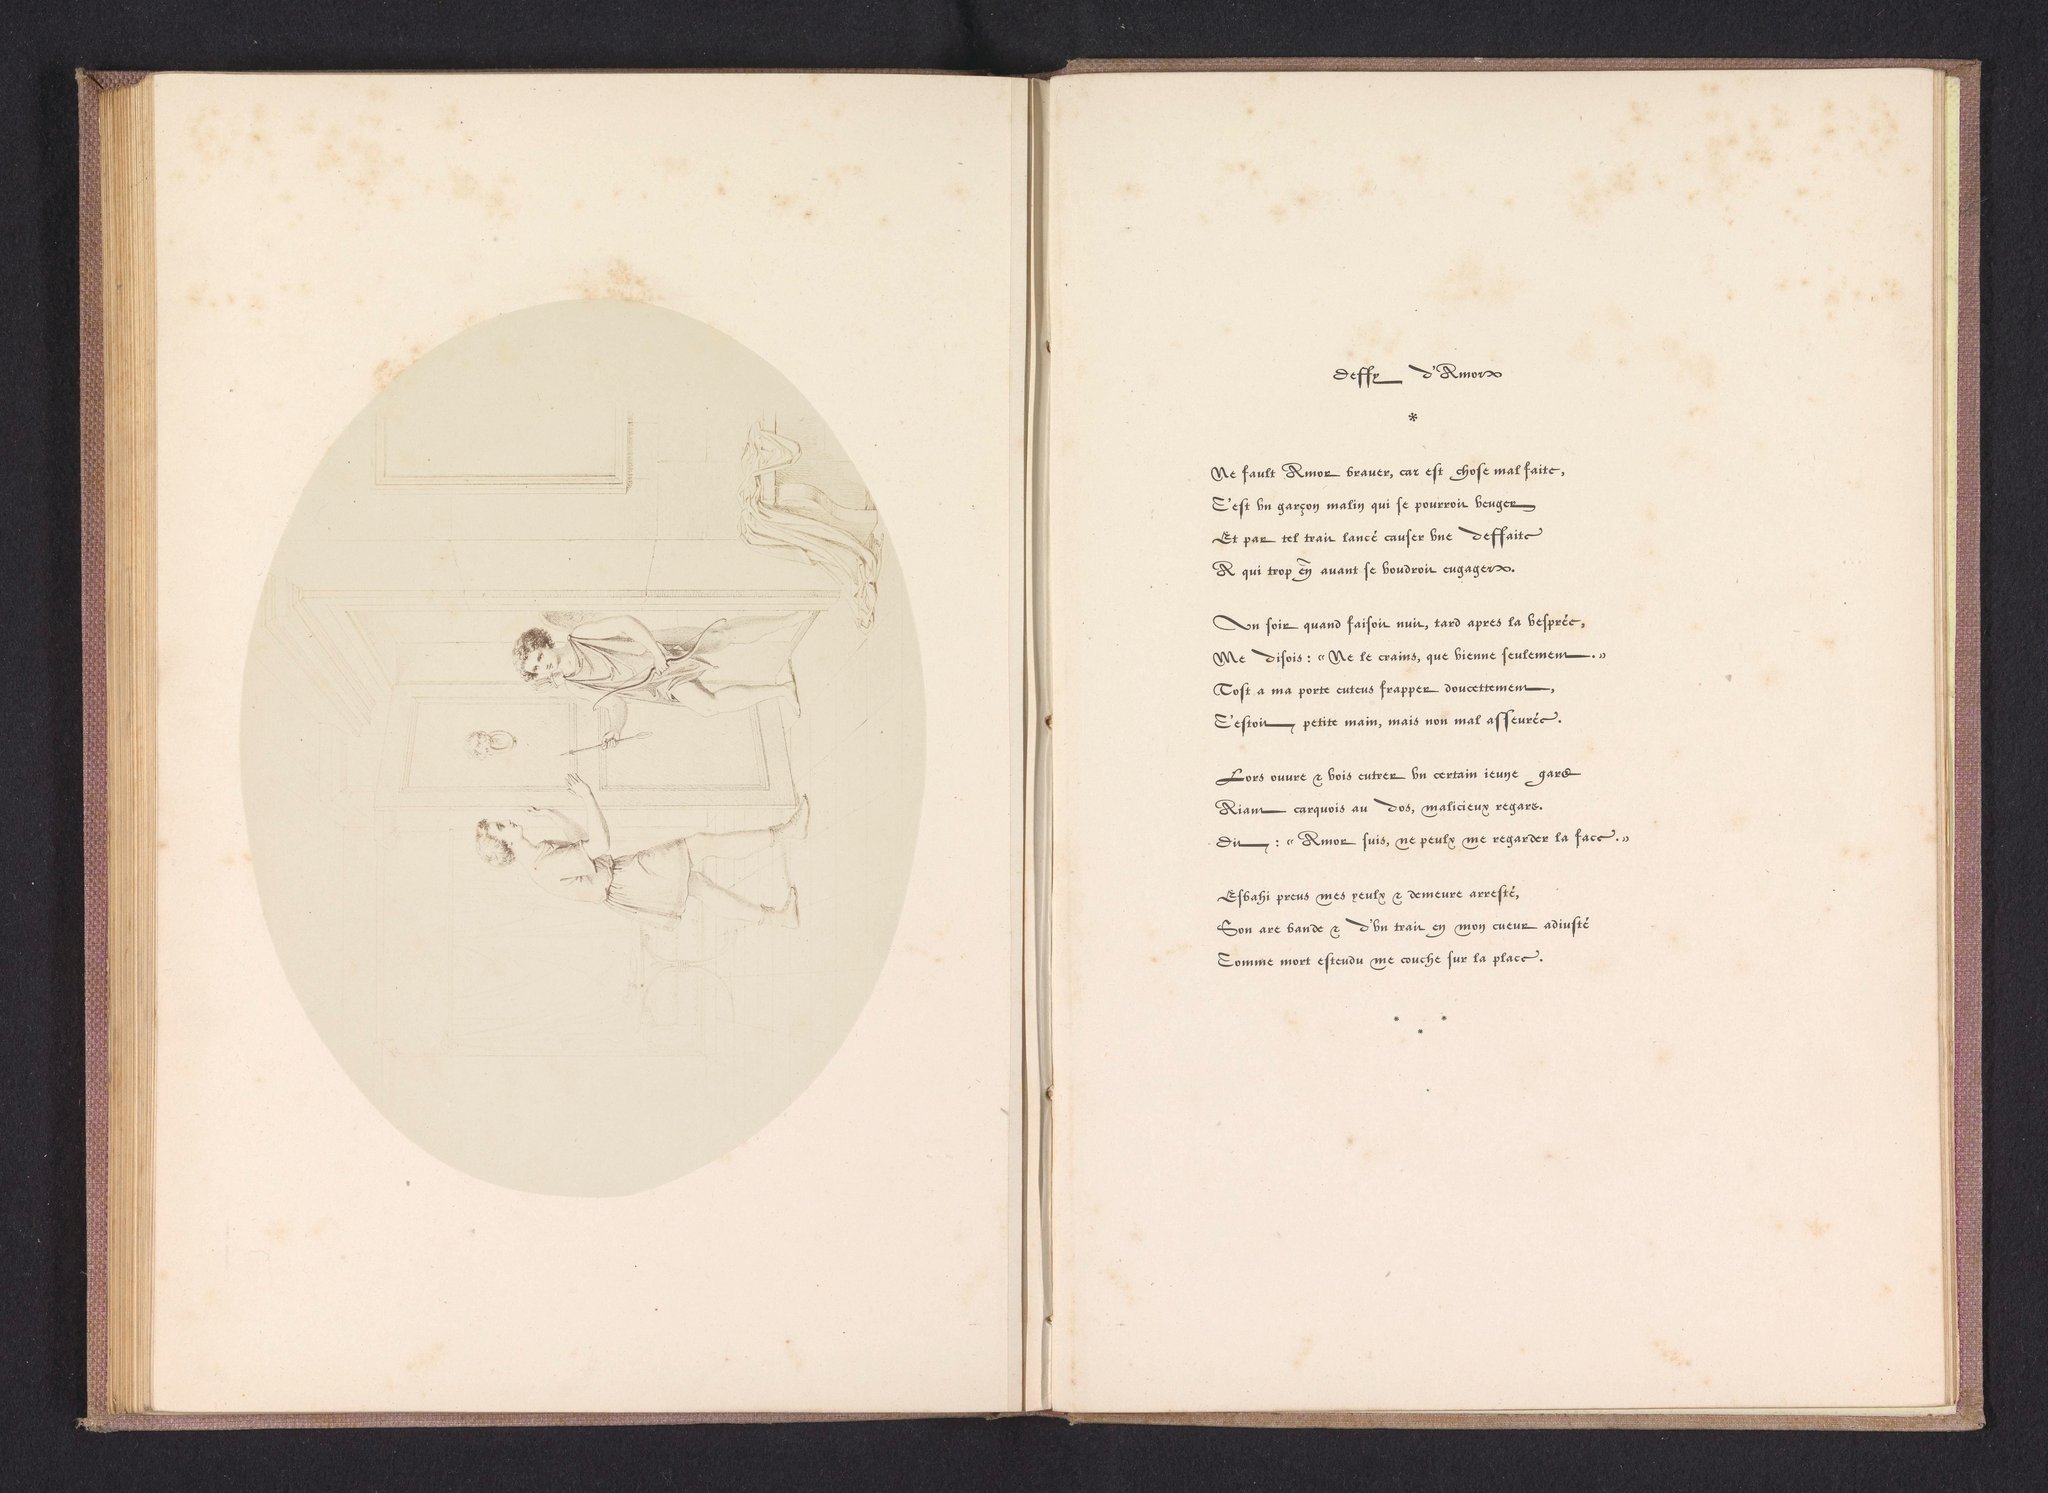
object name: photograph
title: Fotoreproductie van een tekening, voorstellende een man opent de deur voor Amor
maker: Anonymous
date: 1857-1867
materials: photographic support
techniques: albumen print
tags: adult man, (story of) cupid, amor (eros), opening the door